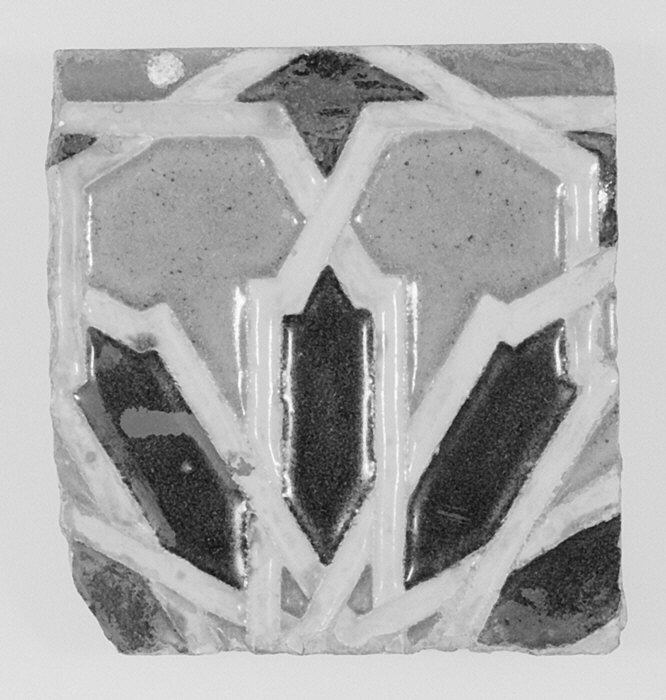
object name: panel fragment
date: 1501-1600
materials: earthenware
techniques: glazing